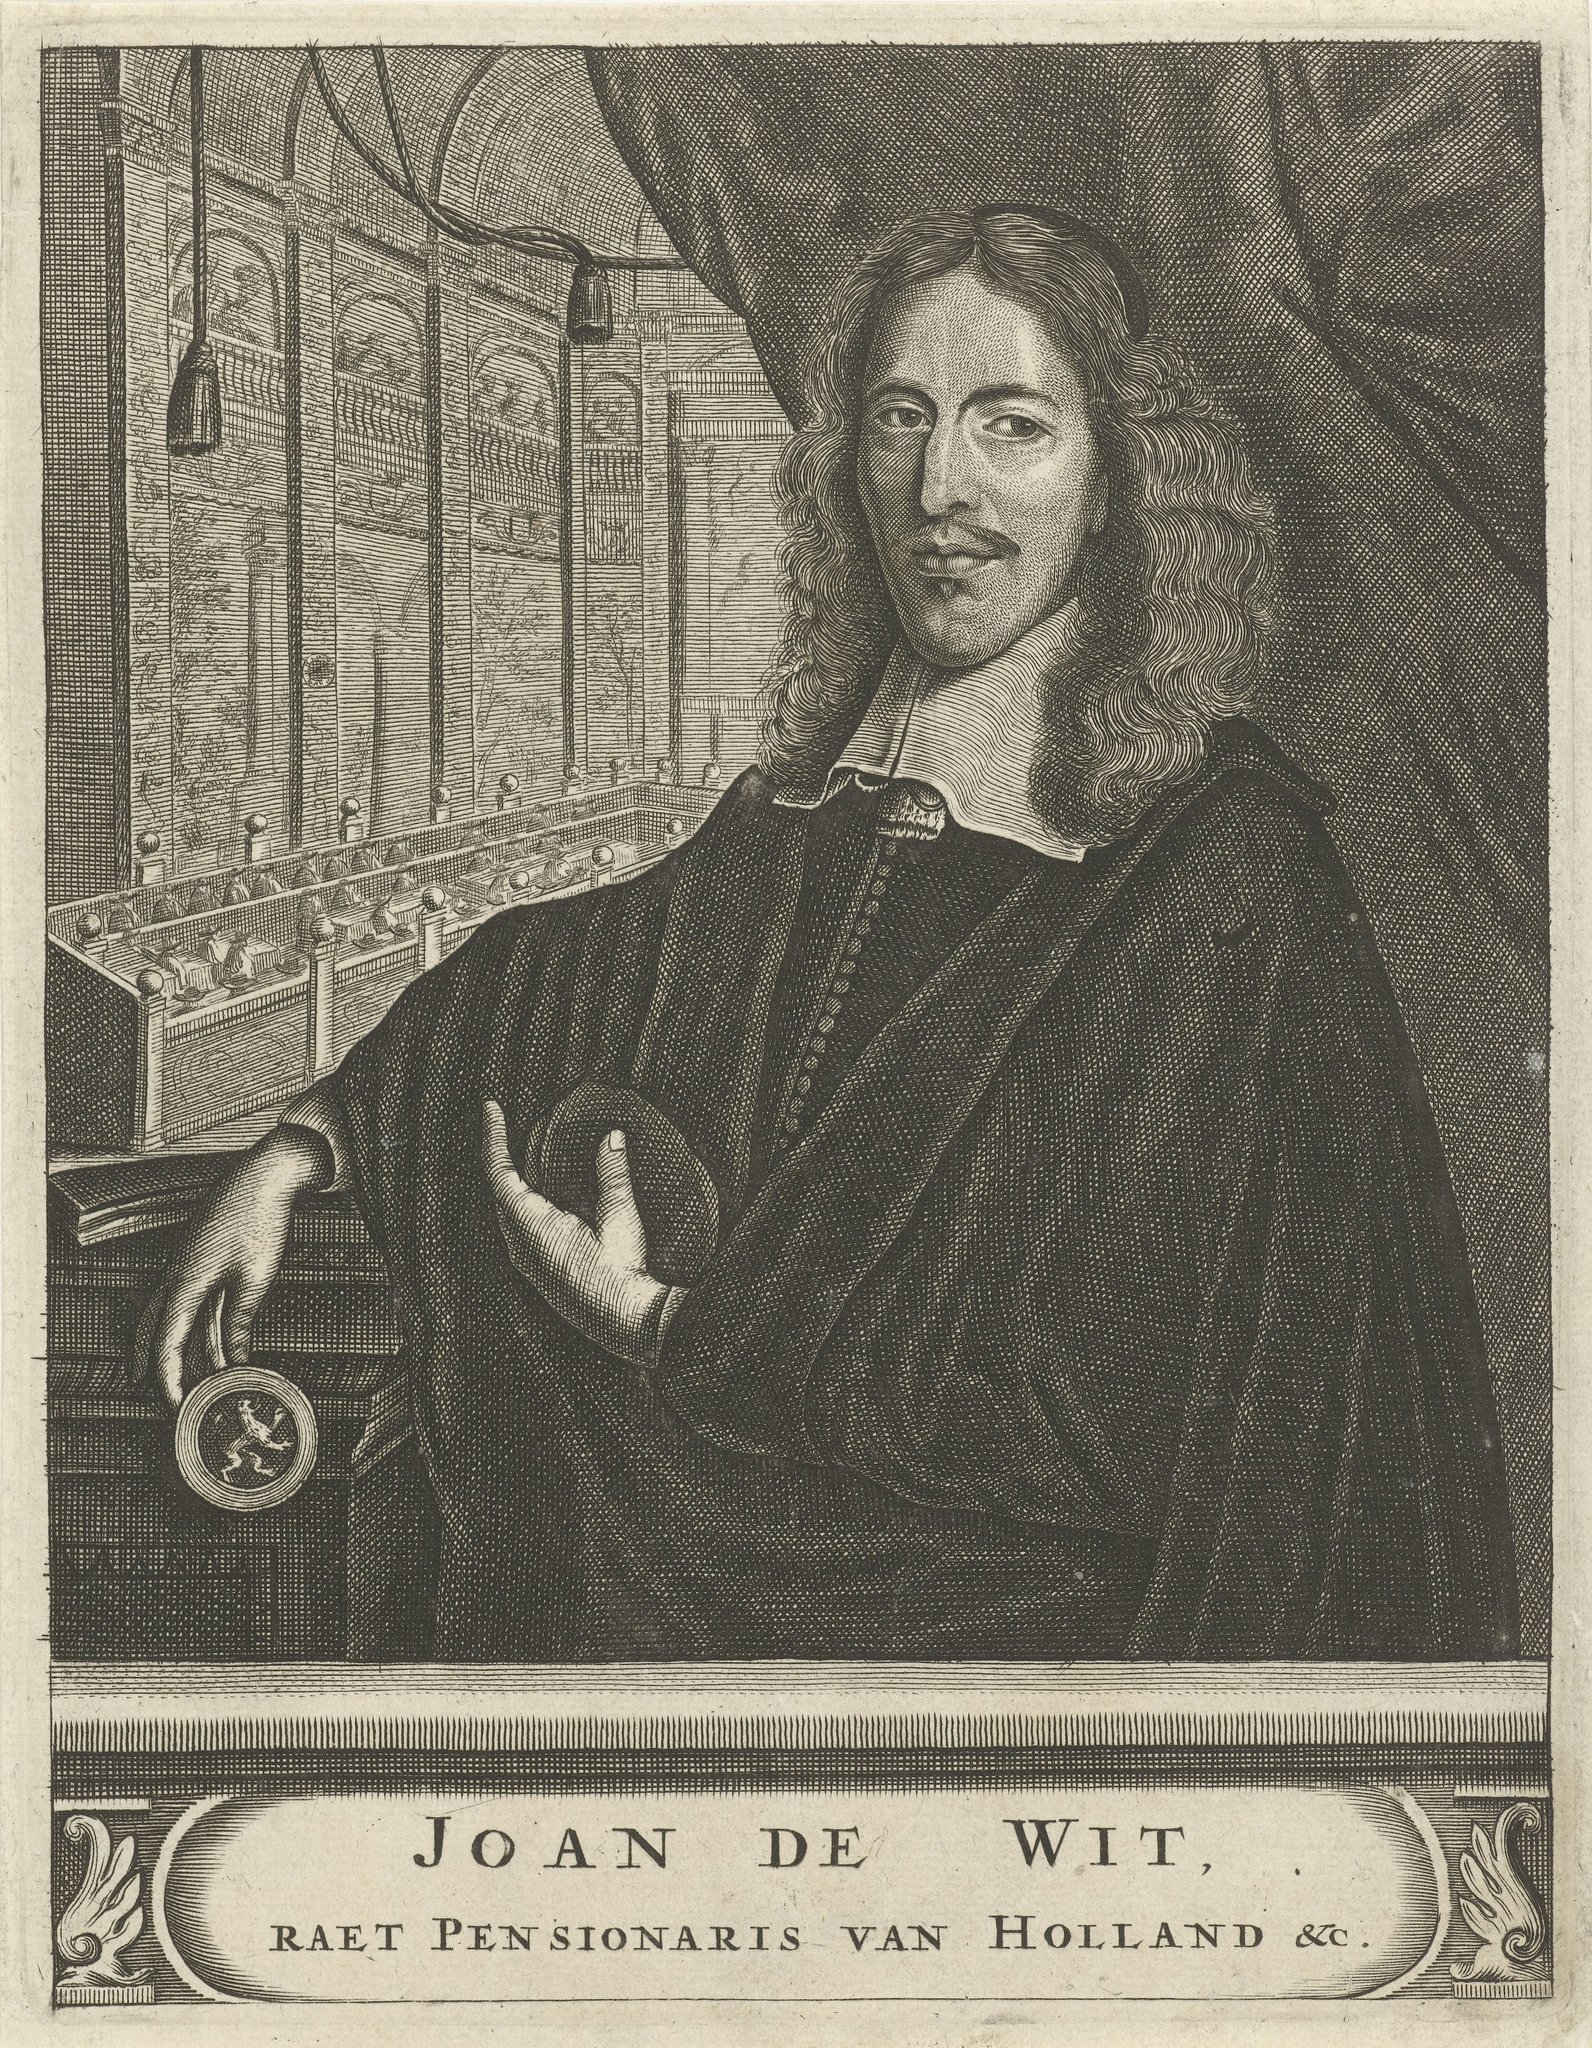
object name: print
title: Portret van Johan de Witt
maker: christiaan hagen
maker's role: draughtsman, print maker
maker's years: 1635-1707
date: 1663-1695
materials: paper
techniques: engraving, etching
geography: amsterdam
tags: the hague, politician, johan de witt, coat (+ men's clothes), seal, stamp, court session (court of justice)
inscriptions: collector's mark: Lugt 2228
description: Portret ten halven lijve van Johan de Witt, gekleed in een mantel en staand voor een gordijn met daarachter een vergaderzaal. In zijn rechterhand een zegel met de Nederlandse leeuw, symbool voor de Republiek. Onder zijn portret een plint met daarop zijn naam en titel in twee regels in een cartouche.